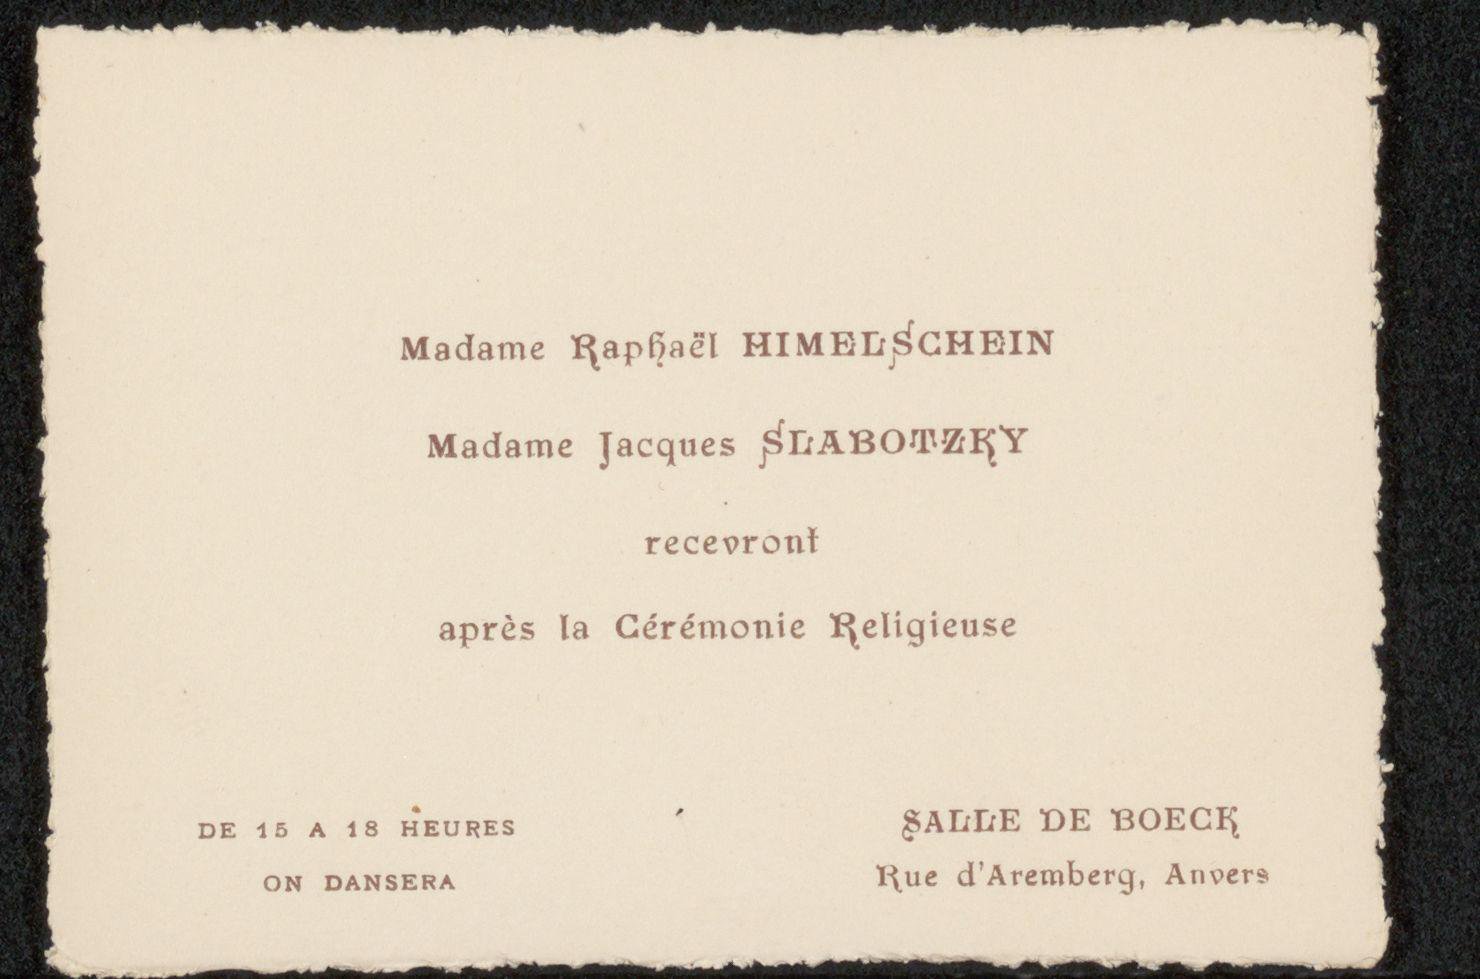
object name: invitation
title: Uitnodiging aan Henriette Wilhelmina van Baak en Philip Zilcken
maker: Anonymous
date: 1921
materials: cardboard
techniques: printing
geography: paris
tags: rose imel, henriette wilhelmina van baak, mevrouw r. himelschein, the hague, painter, draughtsman, philip zilcken, antwerp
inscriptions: collector's mark: ‘RPK’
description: Uitnodiging vormt bijlage bij huwelijksaankondiging RP-D-1982-43-HIMELSCHEIN-DOC.1A.